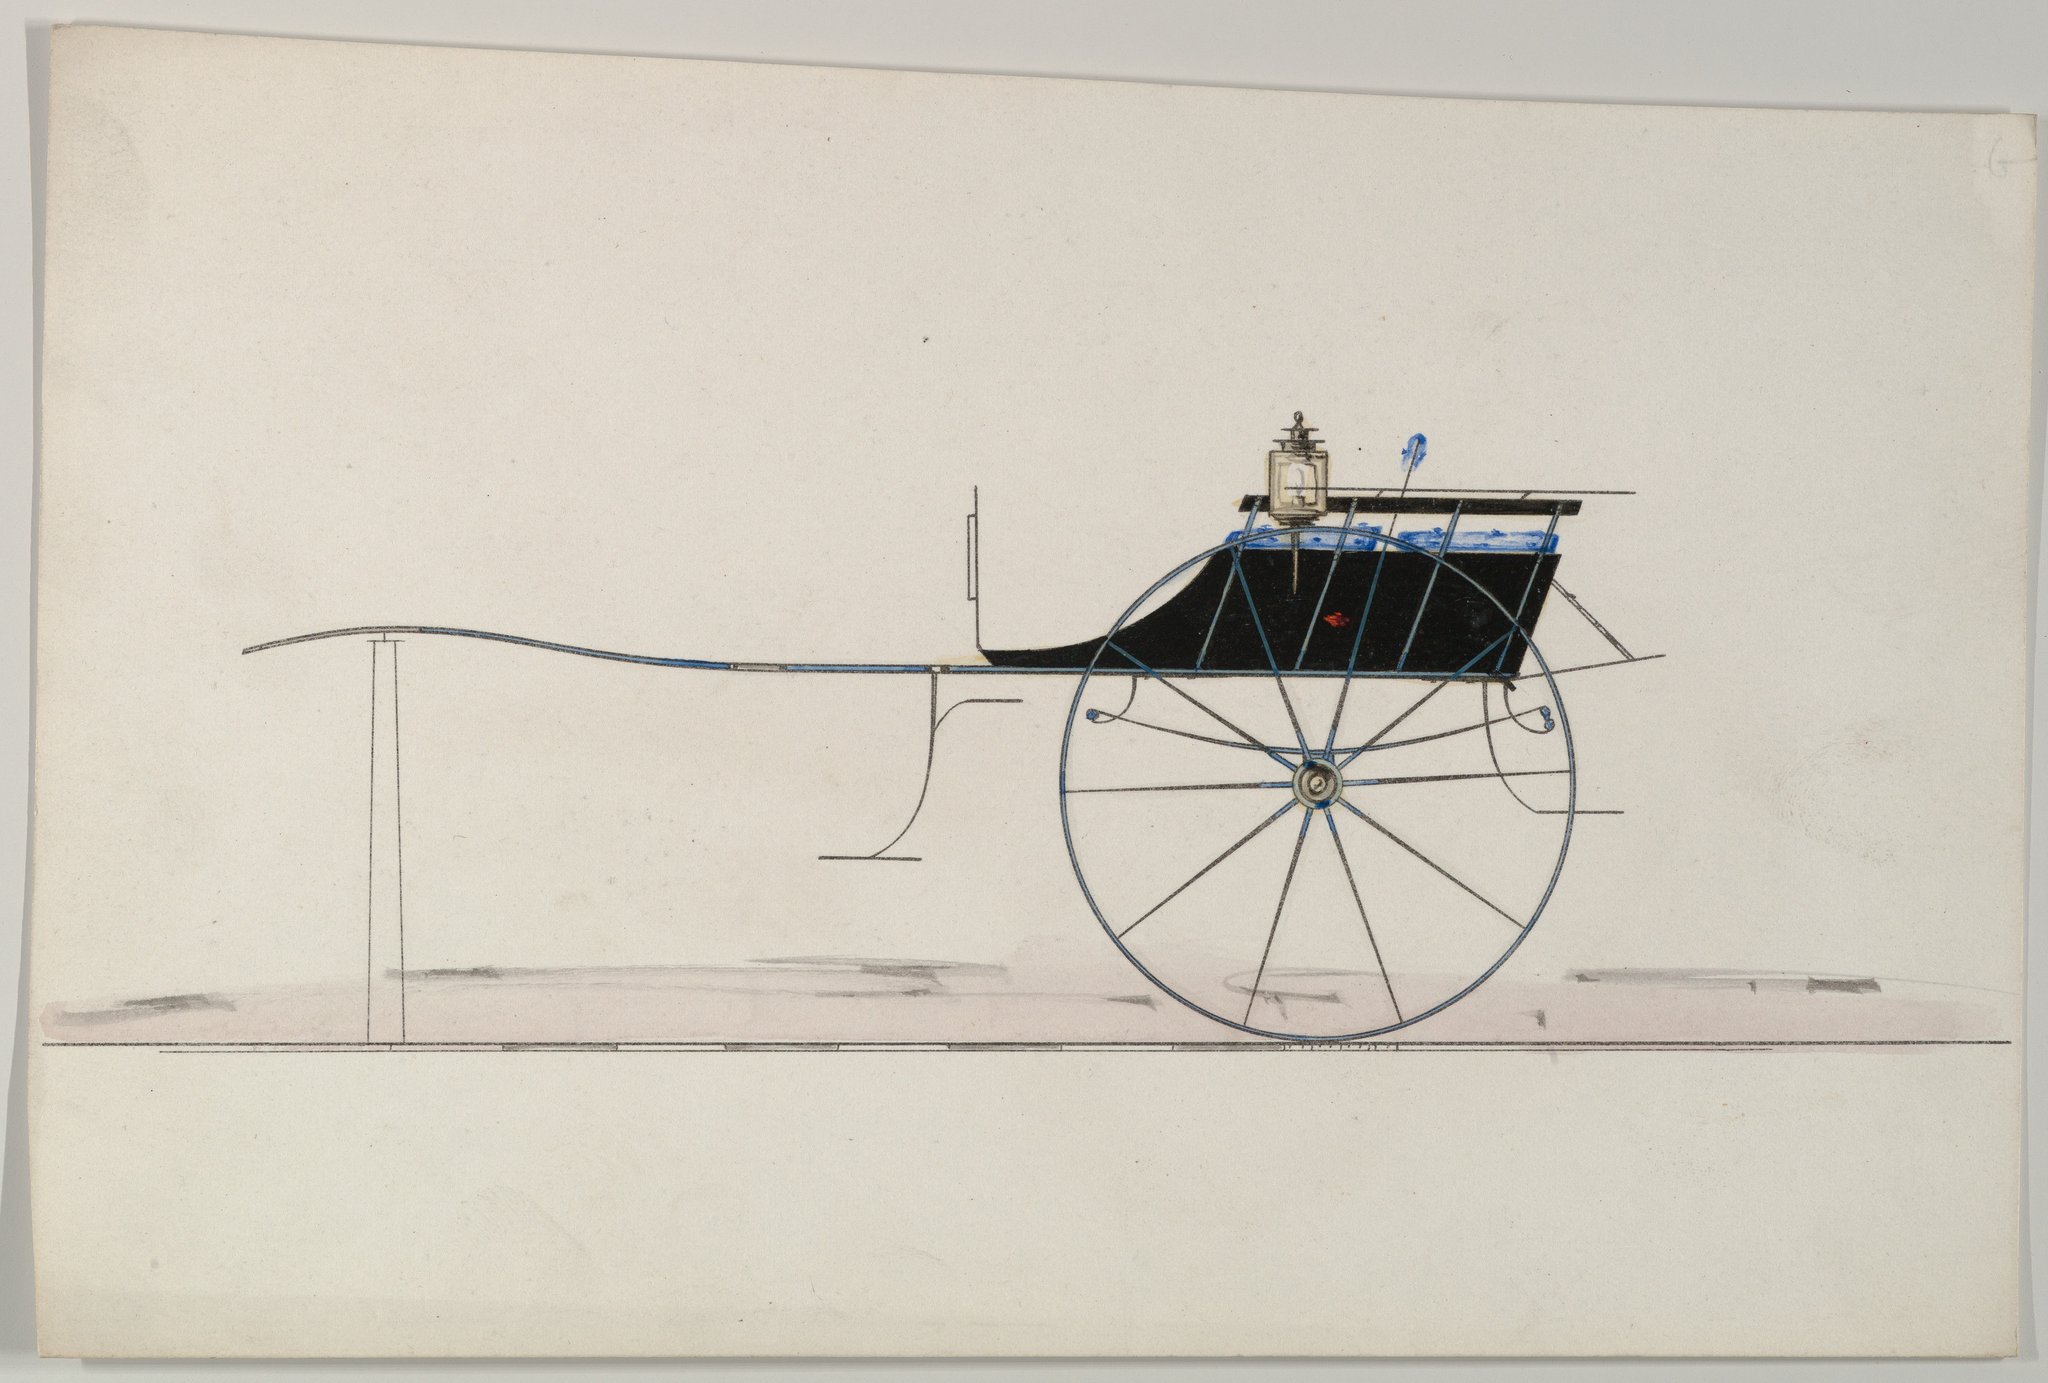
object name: drawing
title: Dog Cart (unnumbered)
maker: brewster & co.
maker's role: manufacturer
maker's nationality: american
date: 1855-1874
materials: gouache, ink, watercolor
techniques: pen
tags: carriages